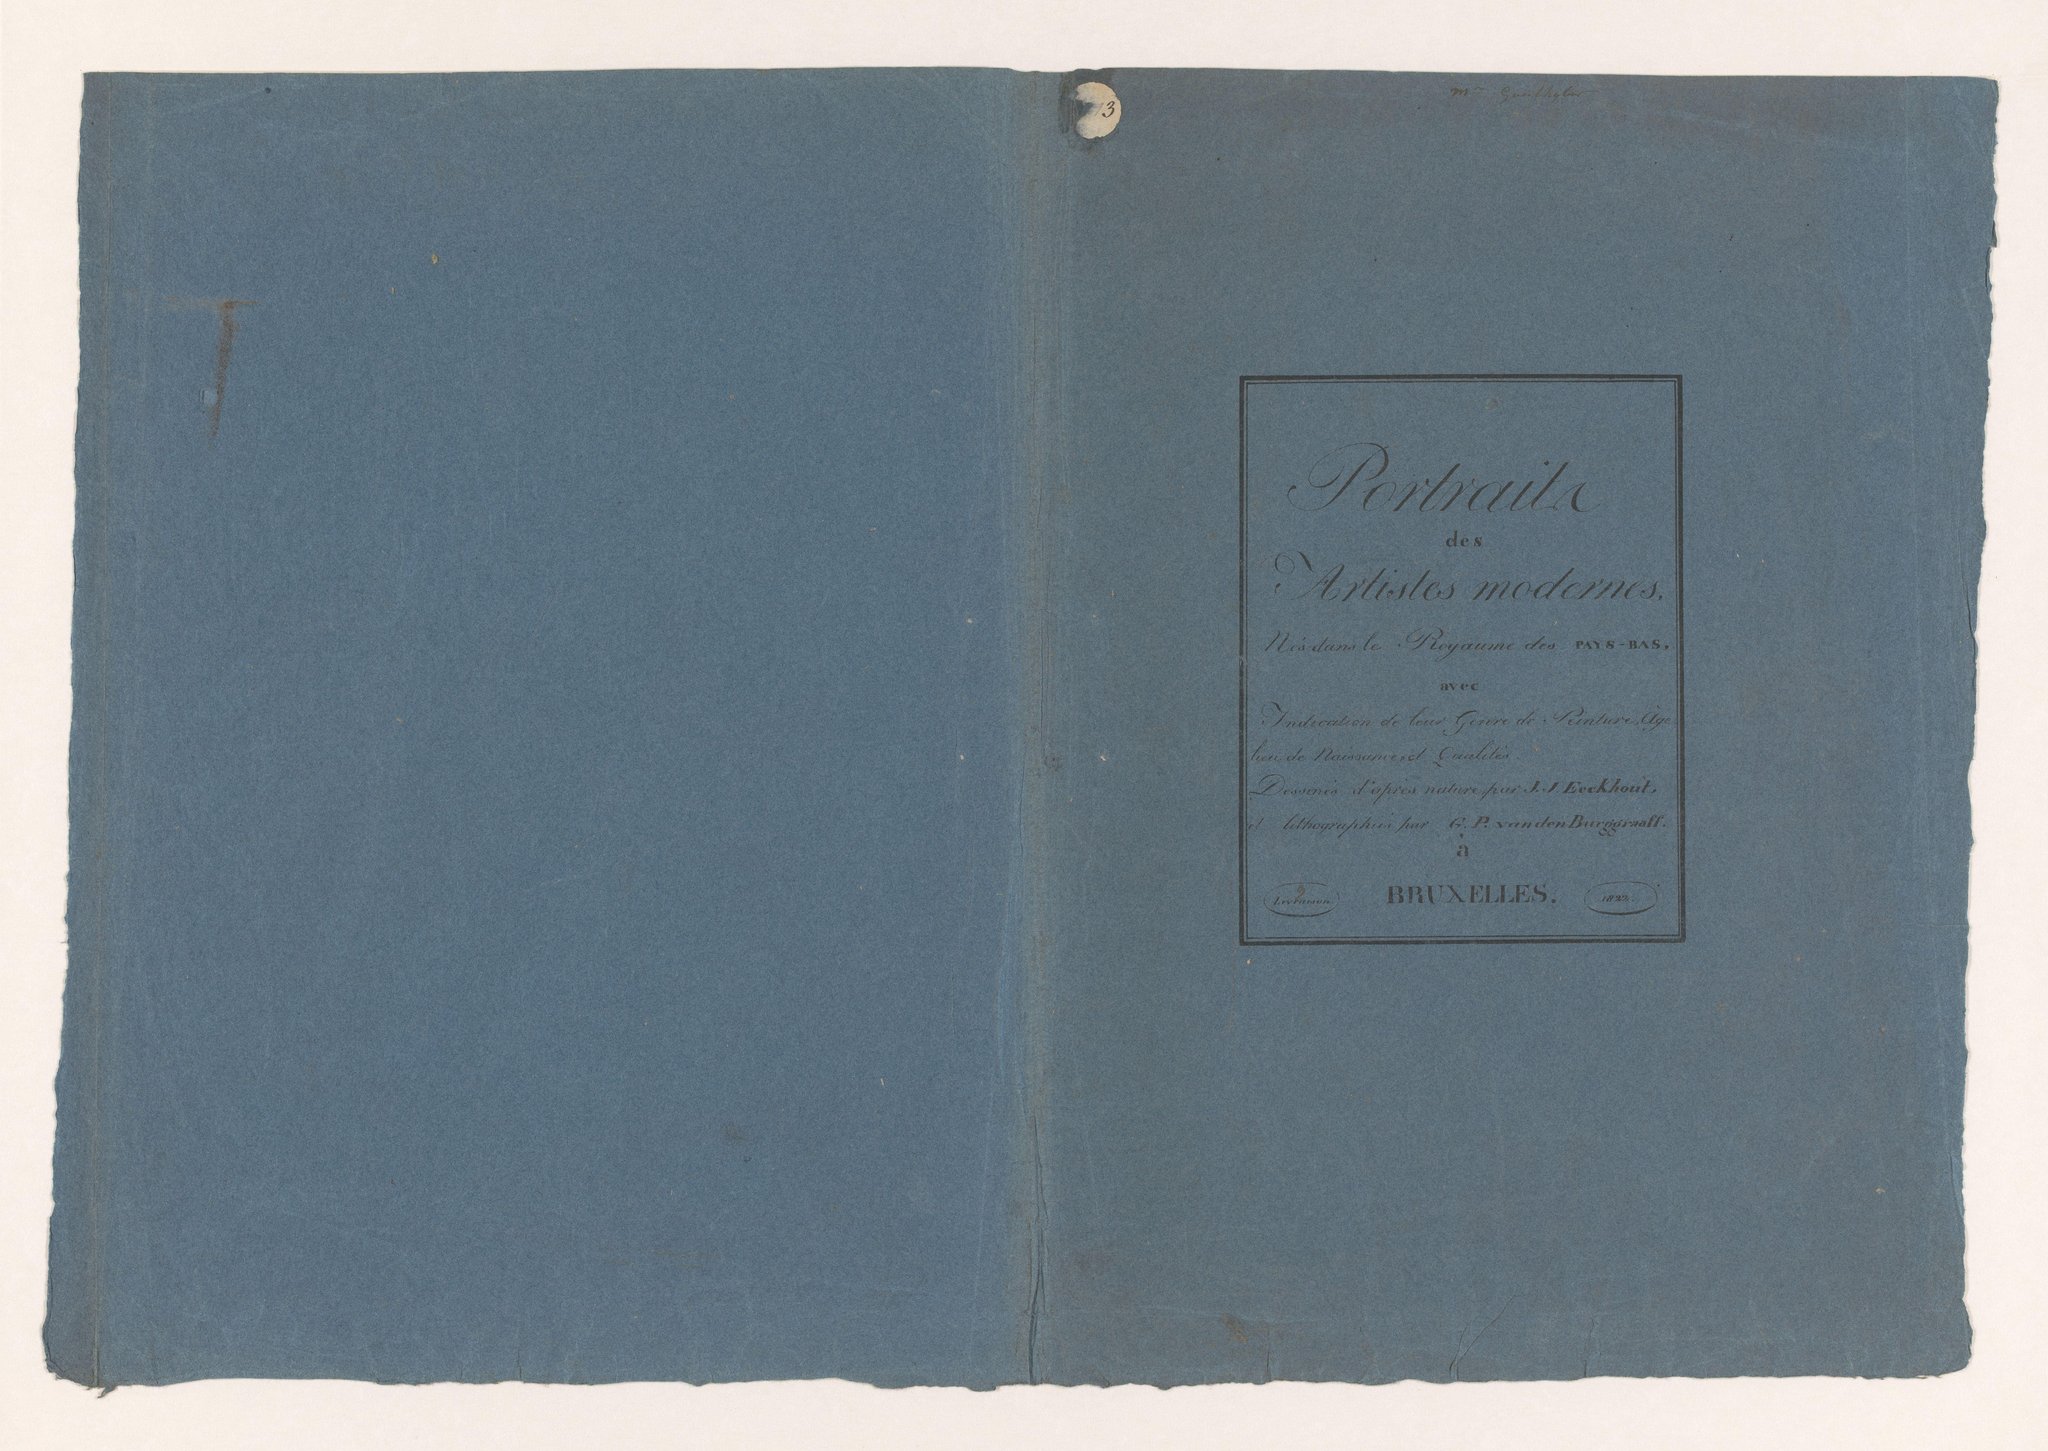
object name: wrapper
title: Portretten van hedendaagse kunstenaars uit het Verenigd Koninkrijk der Nederlanden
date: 1822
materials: paper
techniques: lithograph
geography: brussels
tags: historical persons, portrait, self-portrait of painter, portrait, self-portrait of graphic artist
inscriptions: number: ‘2’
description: Omslag voor het tweede livraison met portretten uit de serie "Portraits des artistes modernes nés dans le Royaume des Pays-Bas". De serie kwam verdeeld over tien cahiers of livraisons uit, elk met daarin zes prenten. Het is echter niet bekend welke prenten bij deze omslag hoorden.